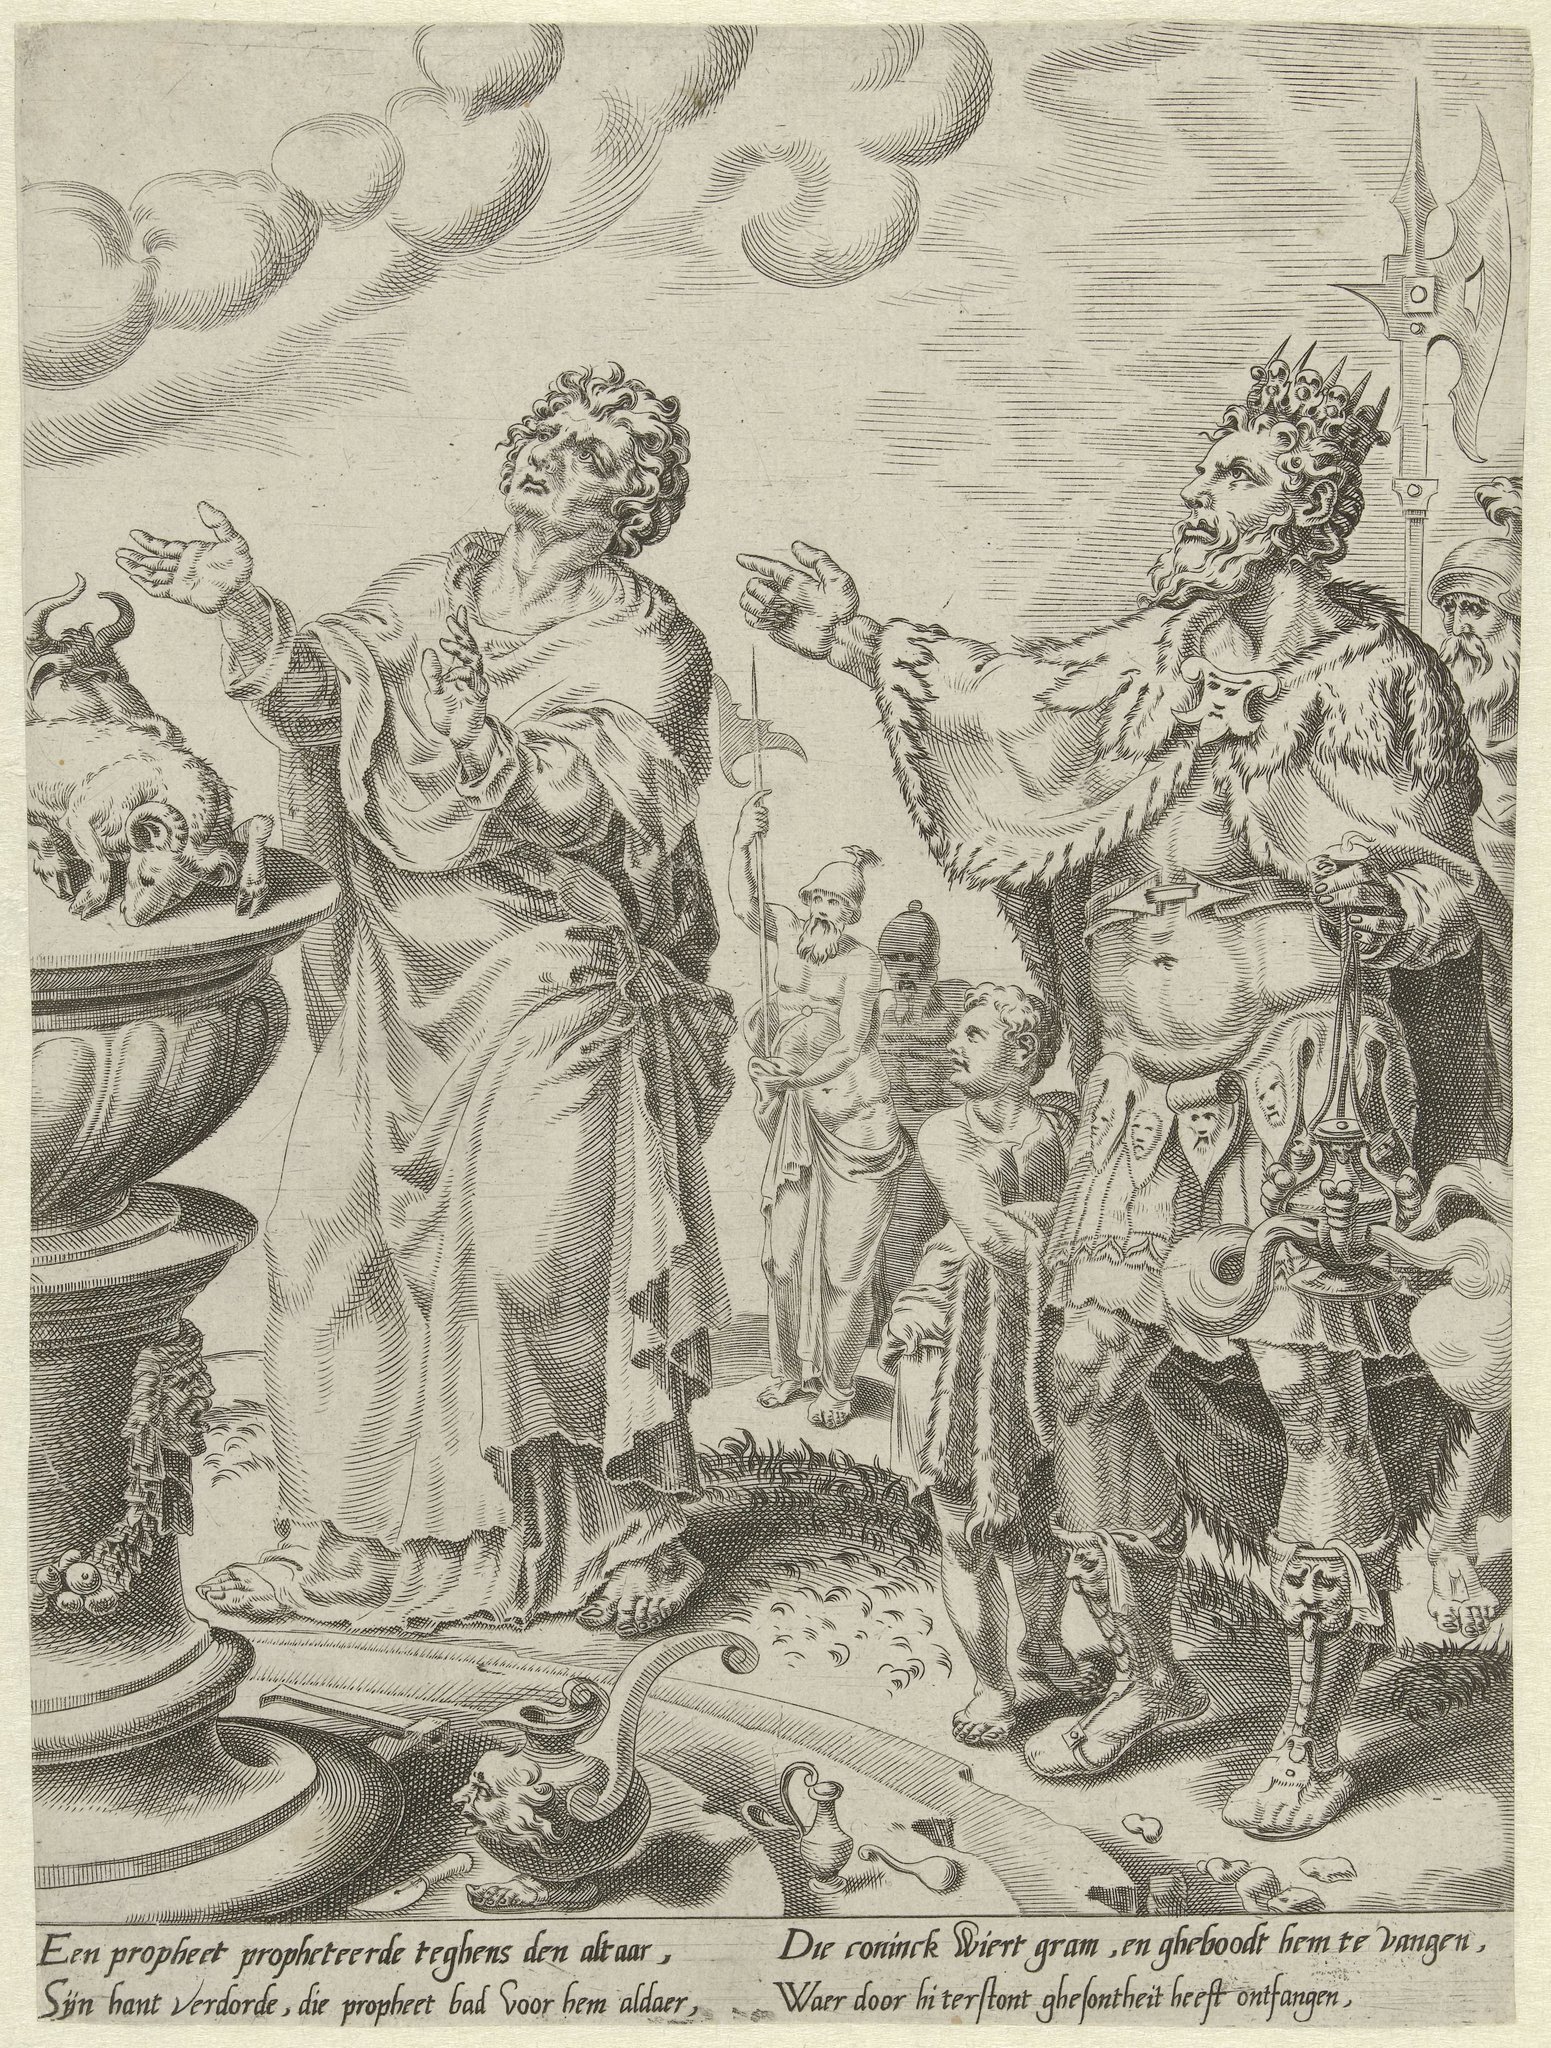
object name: print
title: Verhaal van de ongehoorzame godsman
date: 1548-1554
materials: paper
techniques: engraving, etching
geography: haarlem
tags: as king jeroboam points to the prophet and orders his seizure, his hand withers and the altar falls apart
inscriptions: watermark: Briquet 13998-14023, collector's mark: Lugt 2760, collector's mark: Lugt 2228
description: De godsman doet een voorspelling voor het altaar van Betel (1 Koningen 13: 1-4). Koning Jerobeam probeert hem tegen te houden maar wordt vervloekt. Zijn uitgestrekte arm verdort. De prent heeft een Nederlands onderschrift op rijm en maakt deel uit van een vierdelige serie over de ongehoorzame godsman.